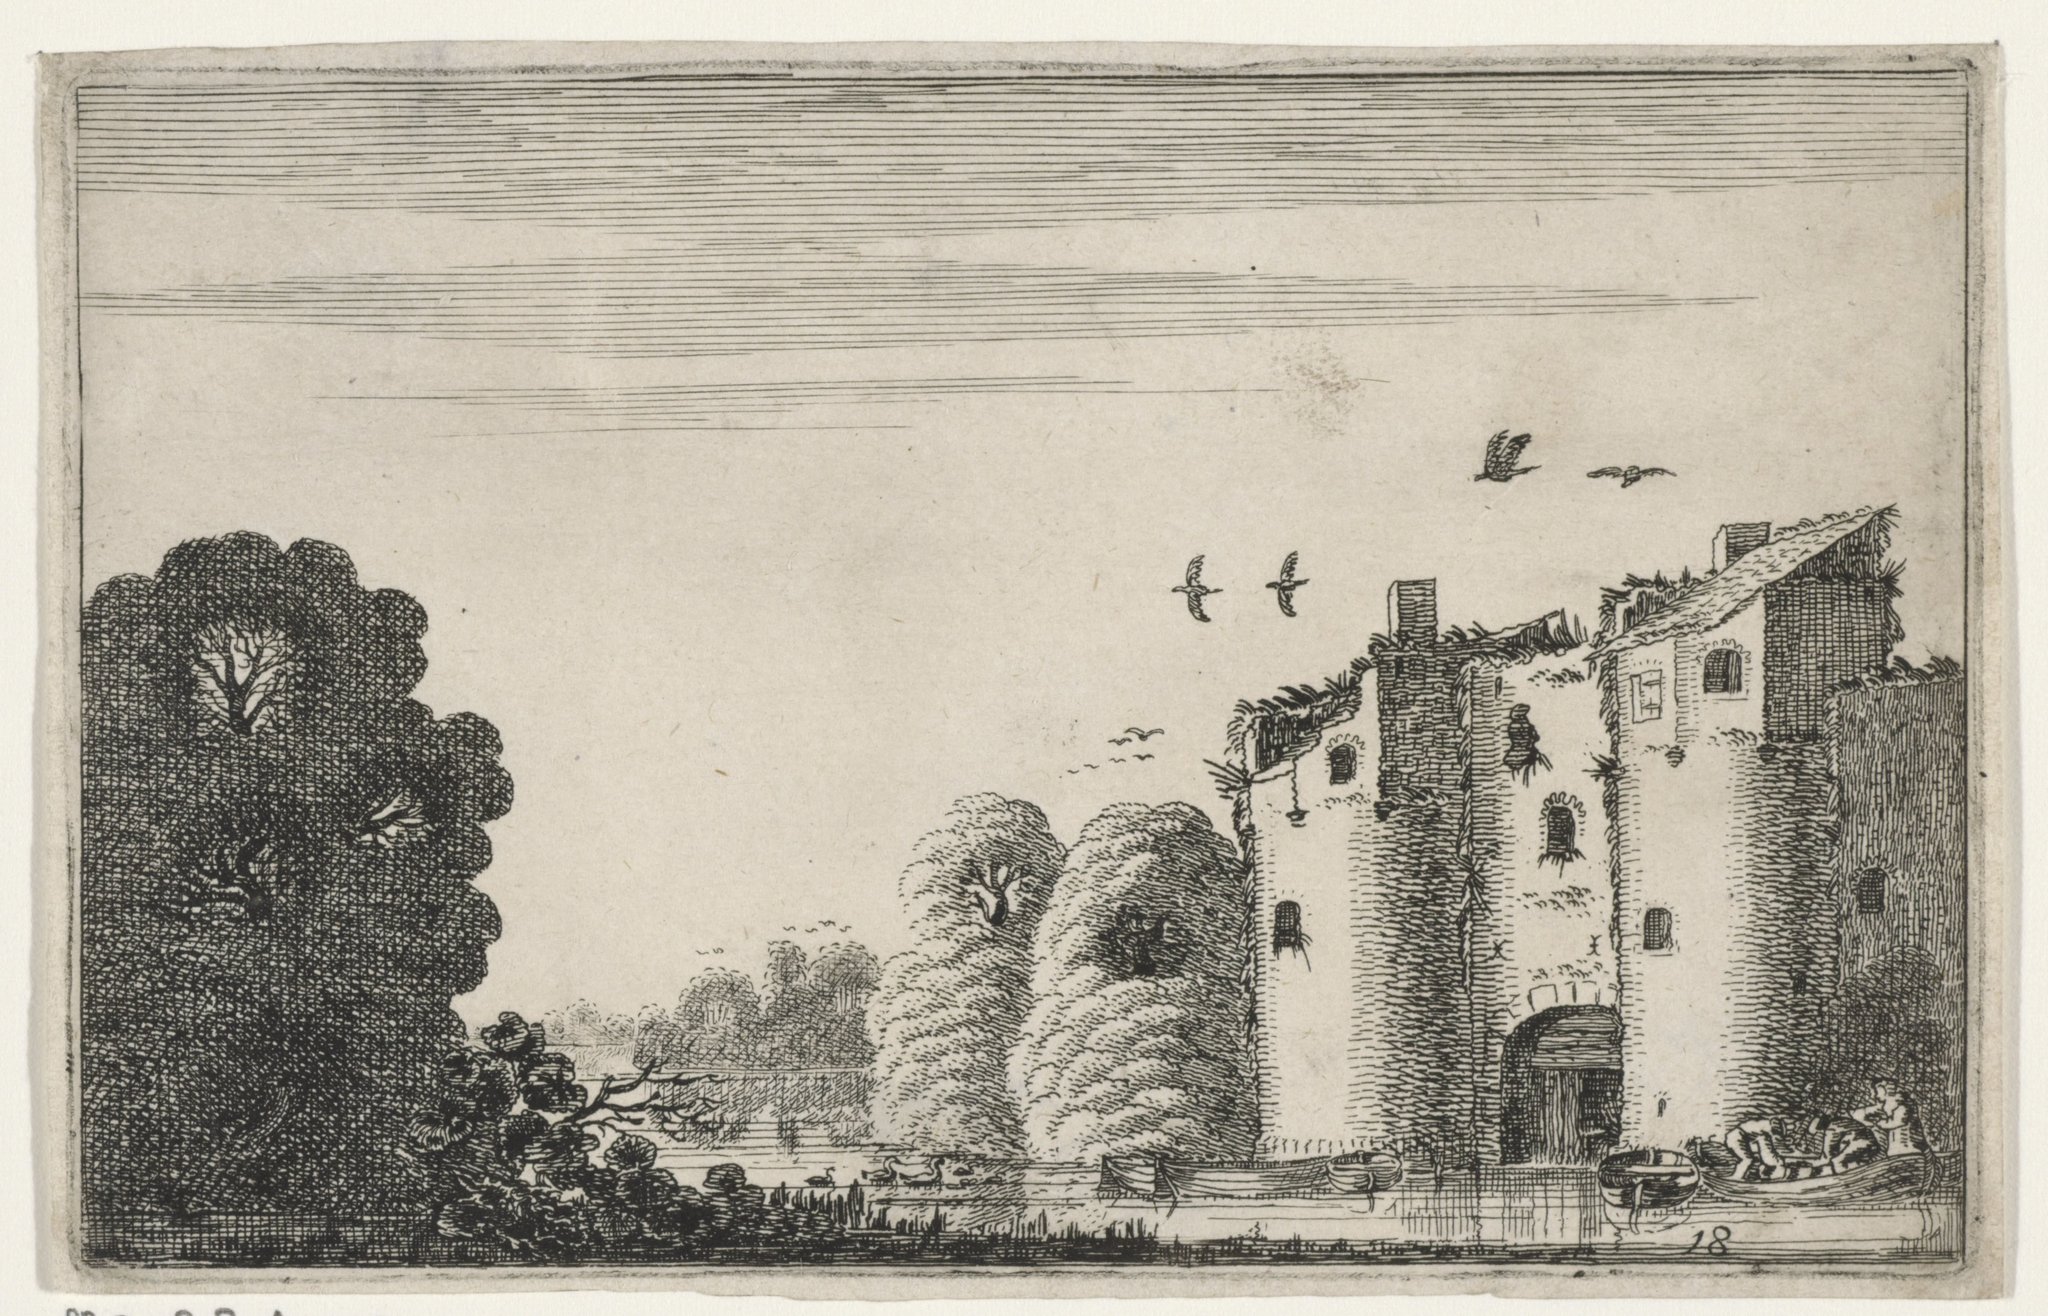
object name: print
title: Figuren in een boot bij een vervallen kasteel aan het water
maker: jan van de velde (ii)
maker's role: draughtsman, painter, print maker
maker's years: 1593-1641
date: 1616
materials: paper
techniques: engraving, etching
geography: northern netherlands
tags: landscape with ruins, ruin of a dwelling, house, castle, etc.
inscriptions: collector's mark: Lugt 964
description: Een boot waarin drie figuren bij een ruïne van een kasteel in een rivierlandschap. Achttiende prent uit een serie van twintig.